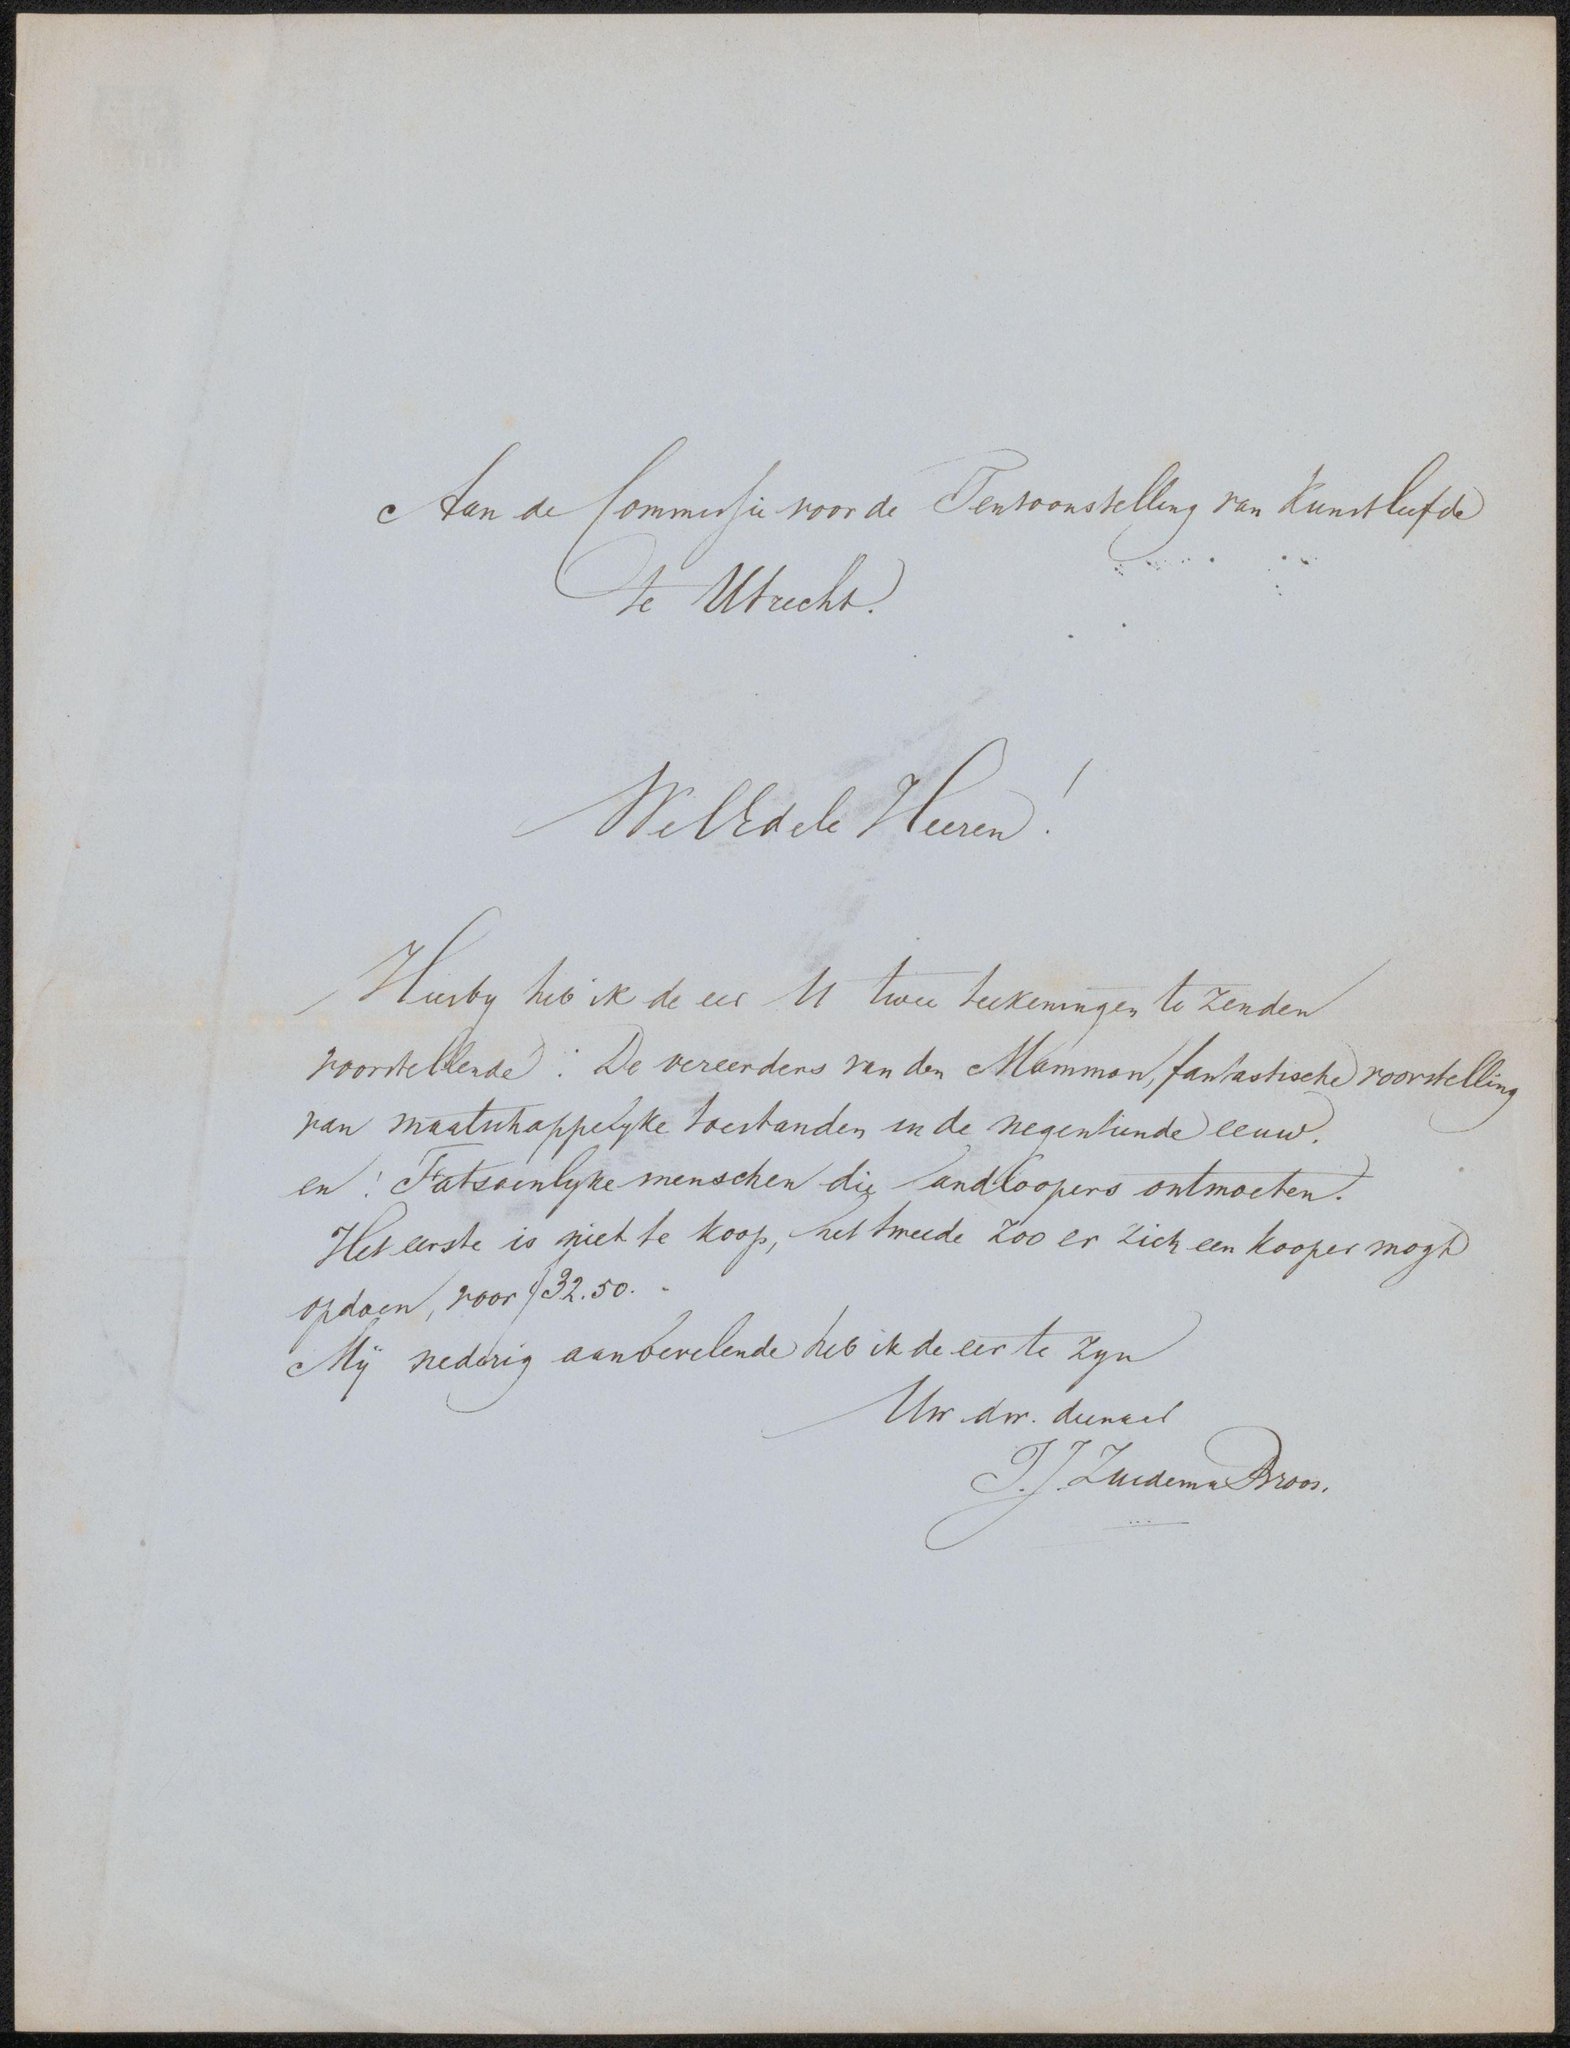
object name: letter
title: Brief aan de Commissie van de Tentoonstelling van Levende Meesters in Utrecht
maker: jan jacob zuidema broos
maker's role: painter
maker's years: 1833-1882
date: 1834-1882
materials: ink, paper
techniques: pen, writing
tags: drawing, money